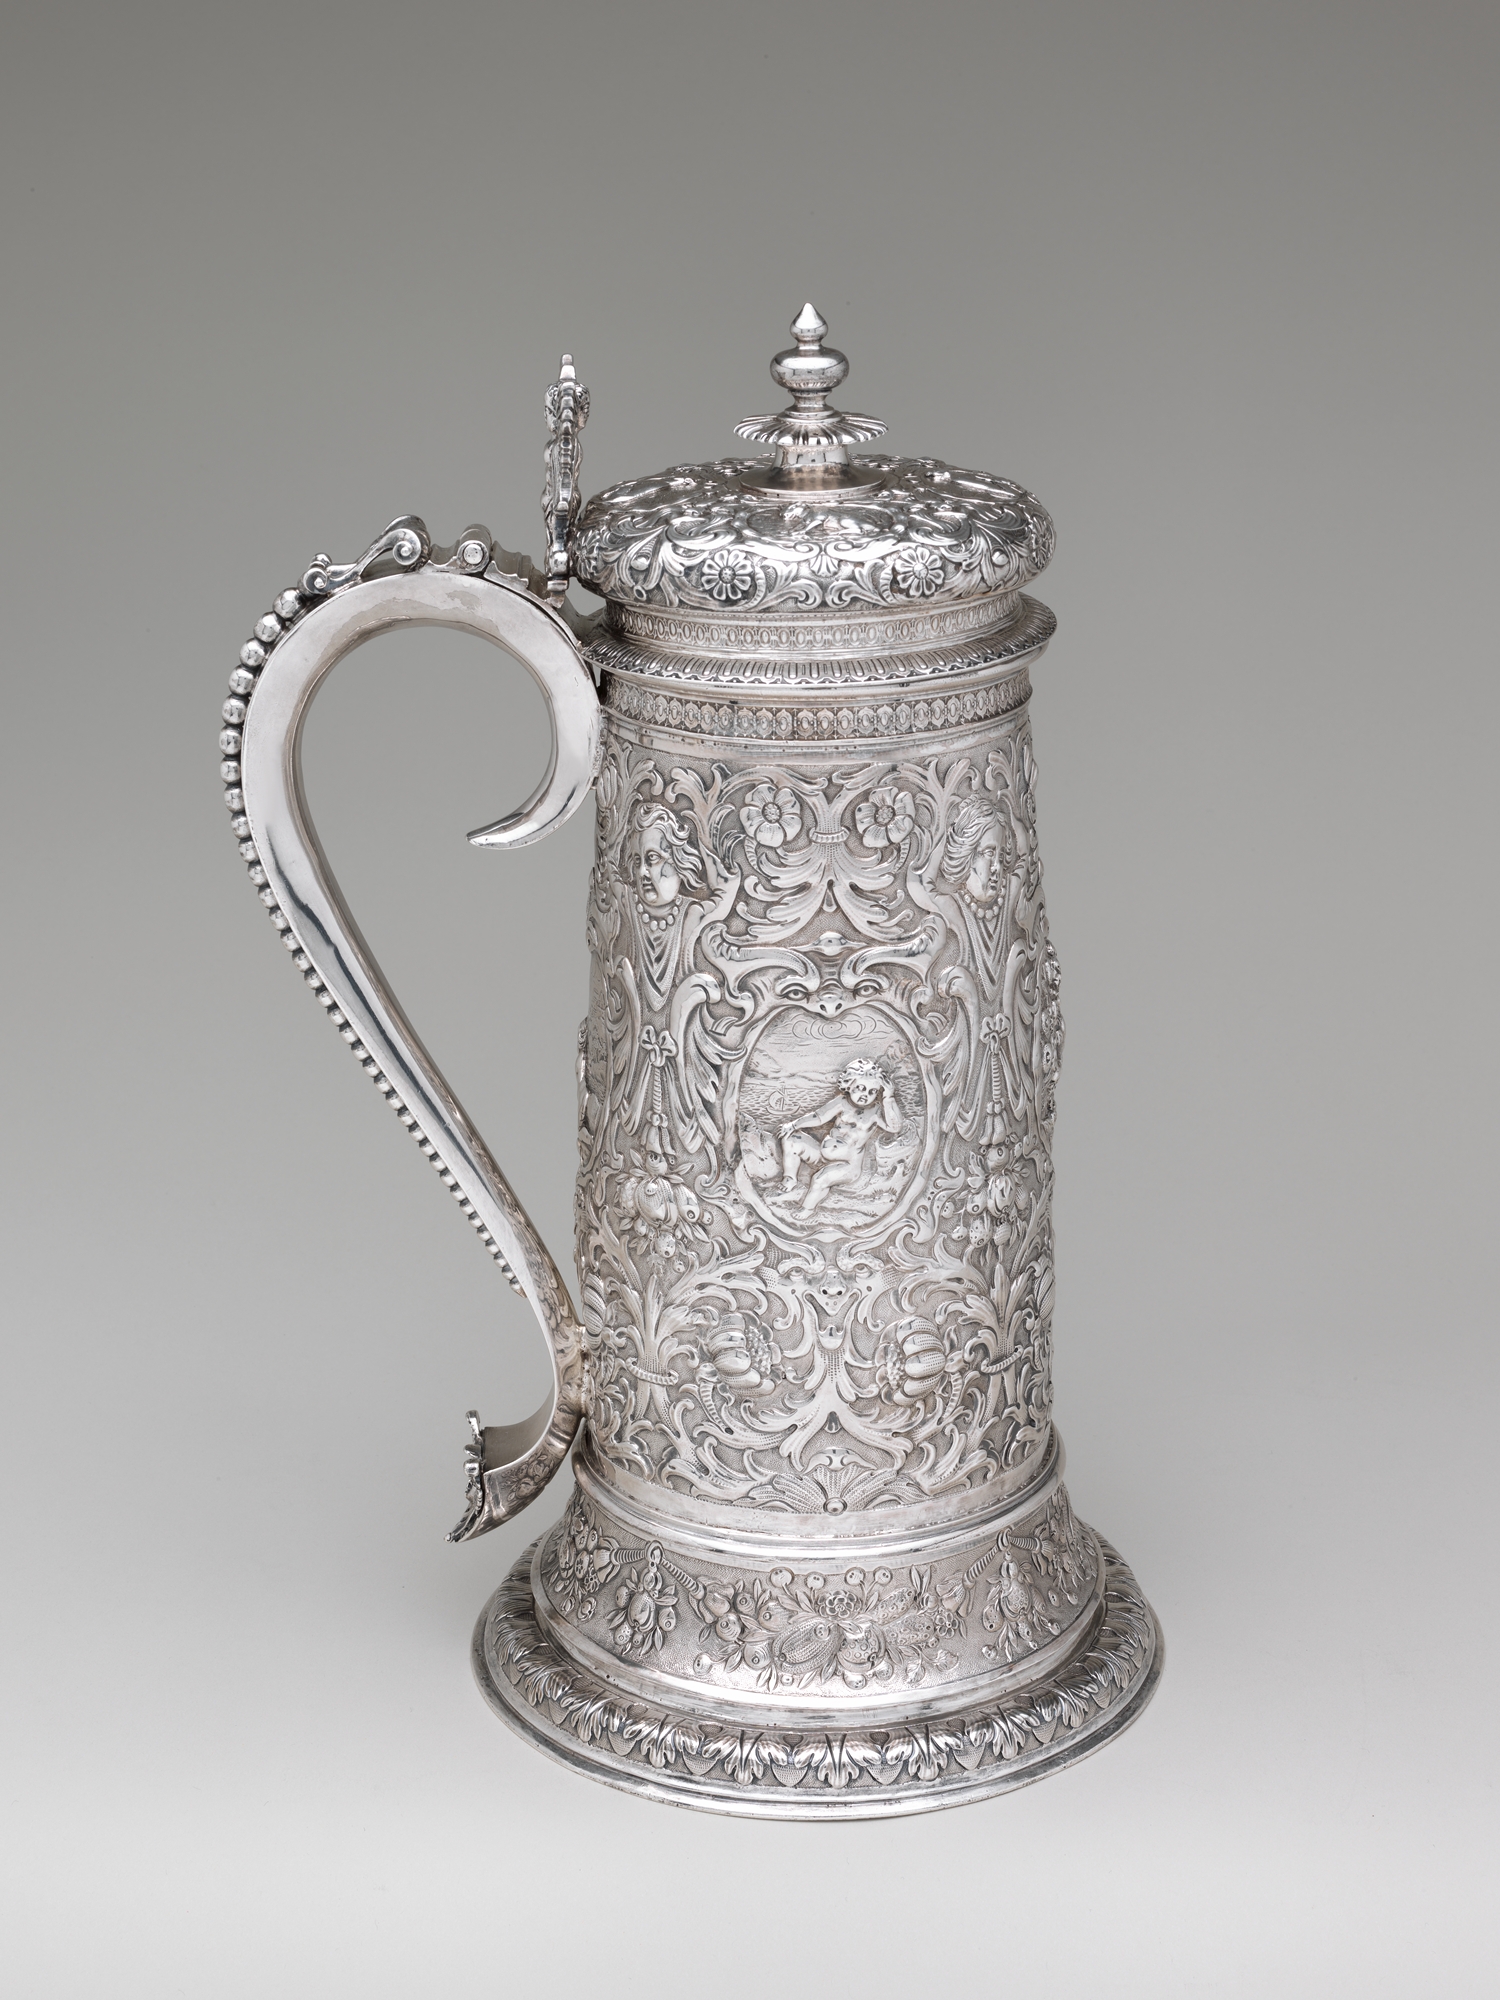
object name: flagon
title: Flagon (one of a pair)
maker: richard blackwell ii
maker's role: maker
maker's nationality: british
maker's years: 1646-1670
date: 1646-1647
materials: silver gilt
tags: bears,children,boars,lions,flowers